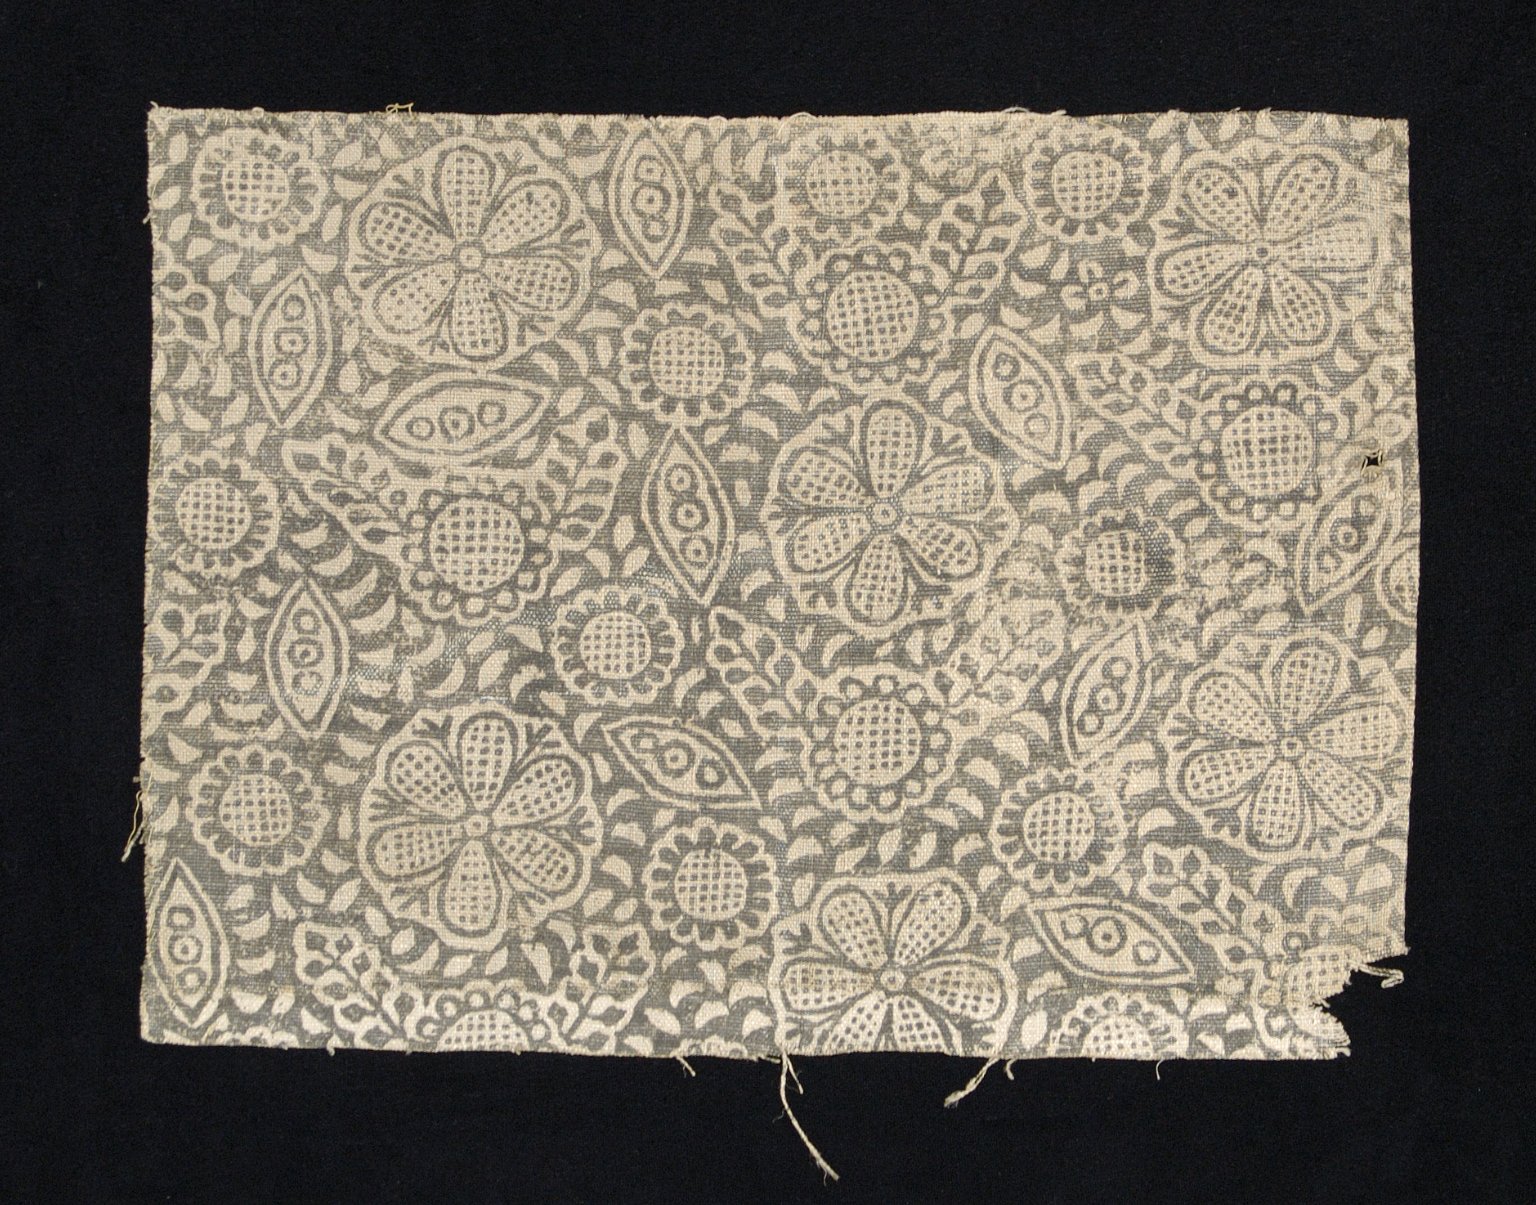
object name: fragment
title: Textile fragment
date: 1700-1899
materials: linen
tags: flowers,leaves